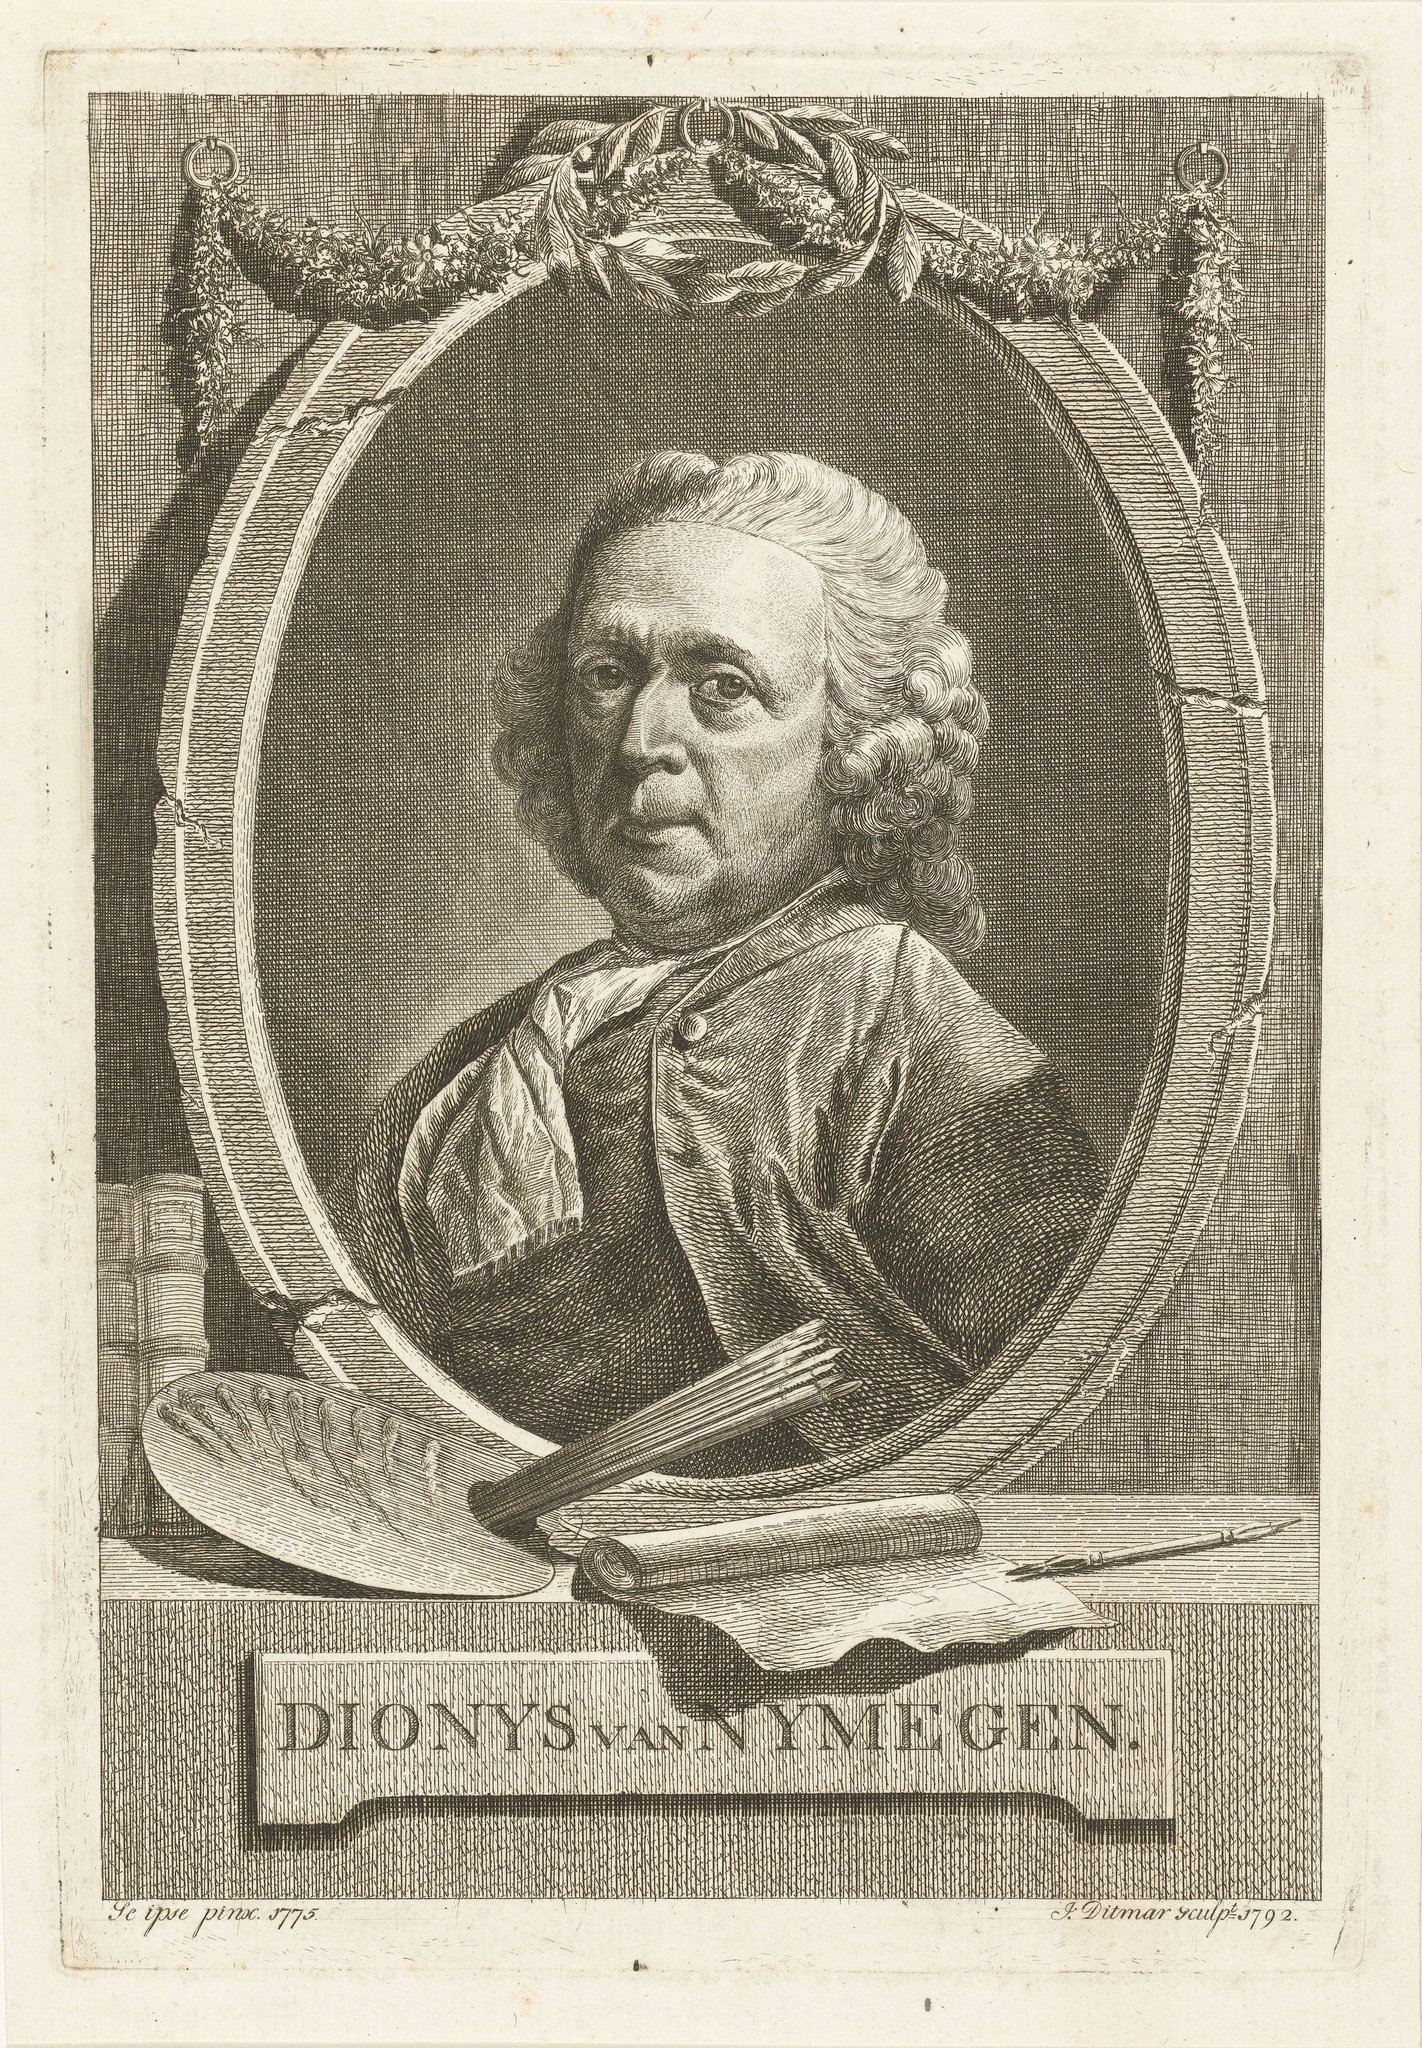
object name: print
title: Portret van Dionys van Nijmegen in ovaal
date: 1792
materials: paper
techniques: etching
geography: amsterdam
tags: painter, draughtsman, dionys van nijmegen, portrait, self-portrait of painter, tools, implements of painter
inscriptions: collector's mark: Lugt 2228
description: Portret van kunstenaar Dionys van Nijmegen, borststuk in ovale lijst versierd met guirlande, voor het portret liggen onder andere een schilderspalet en penselen.